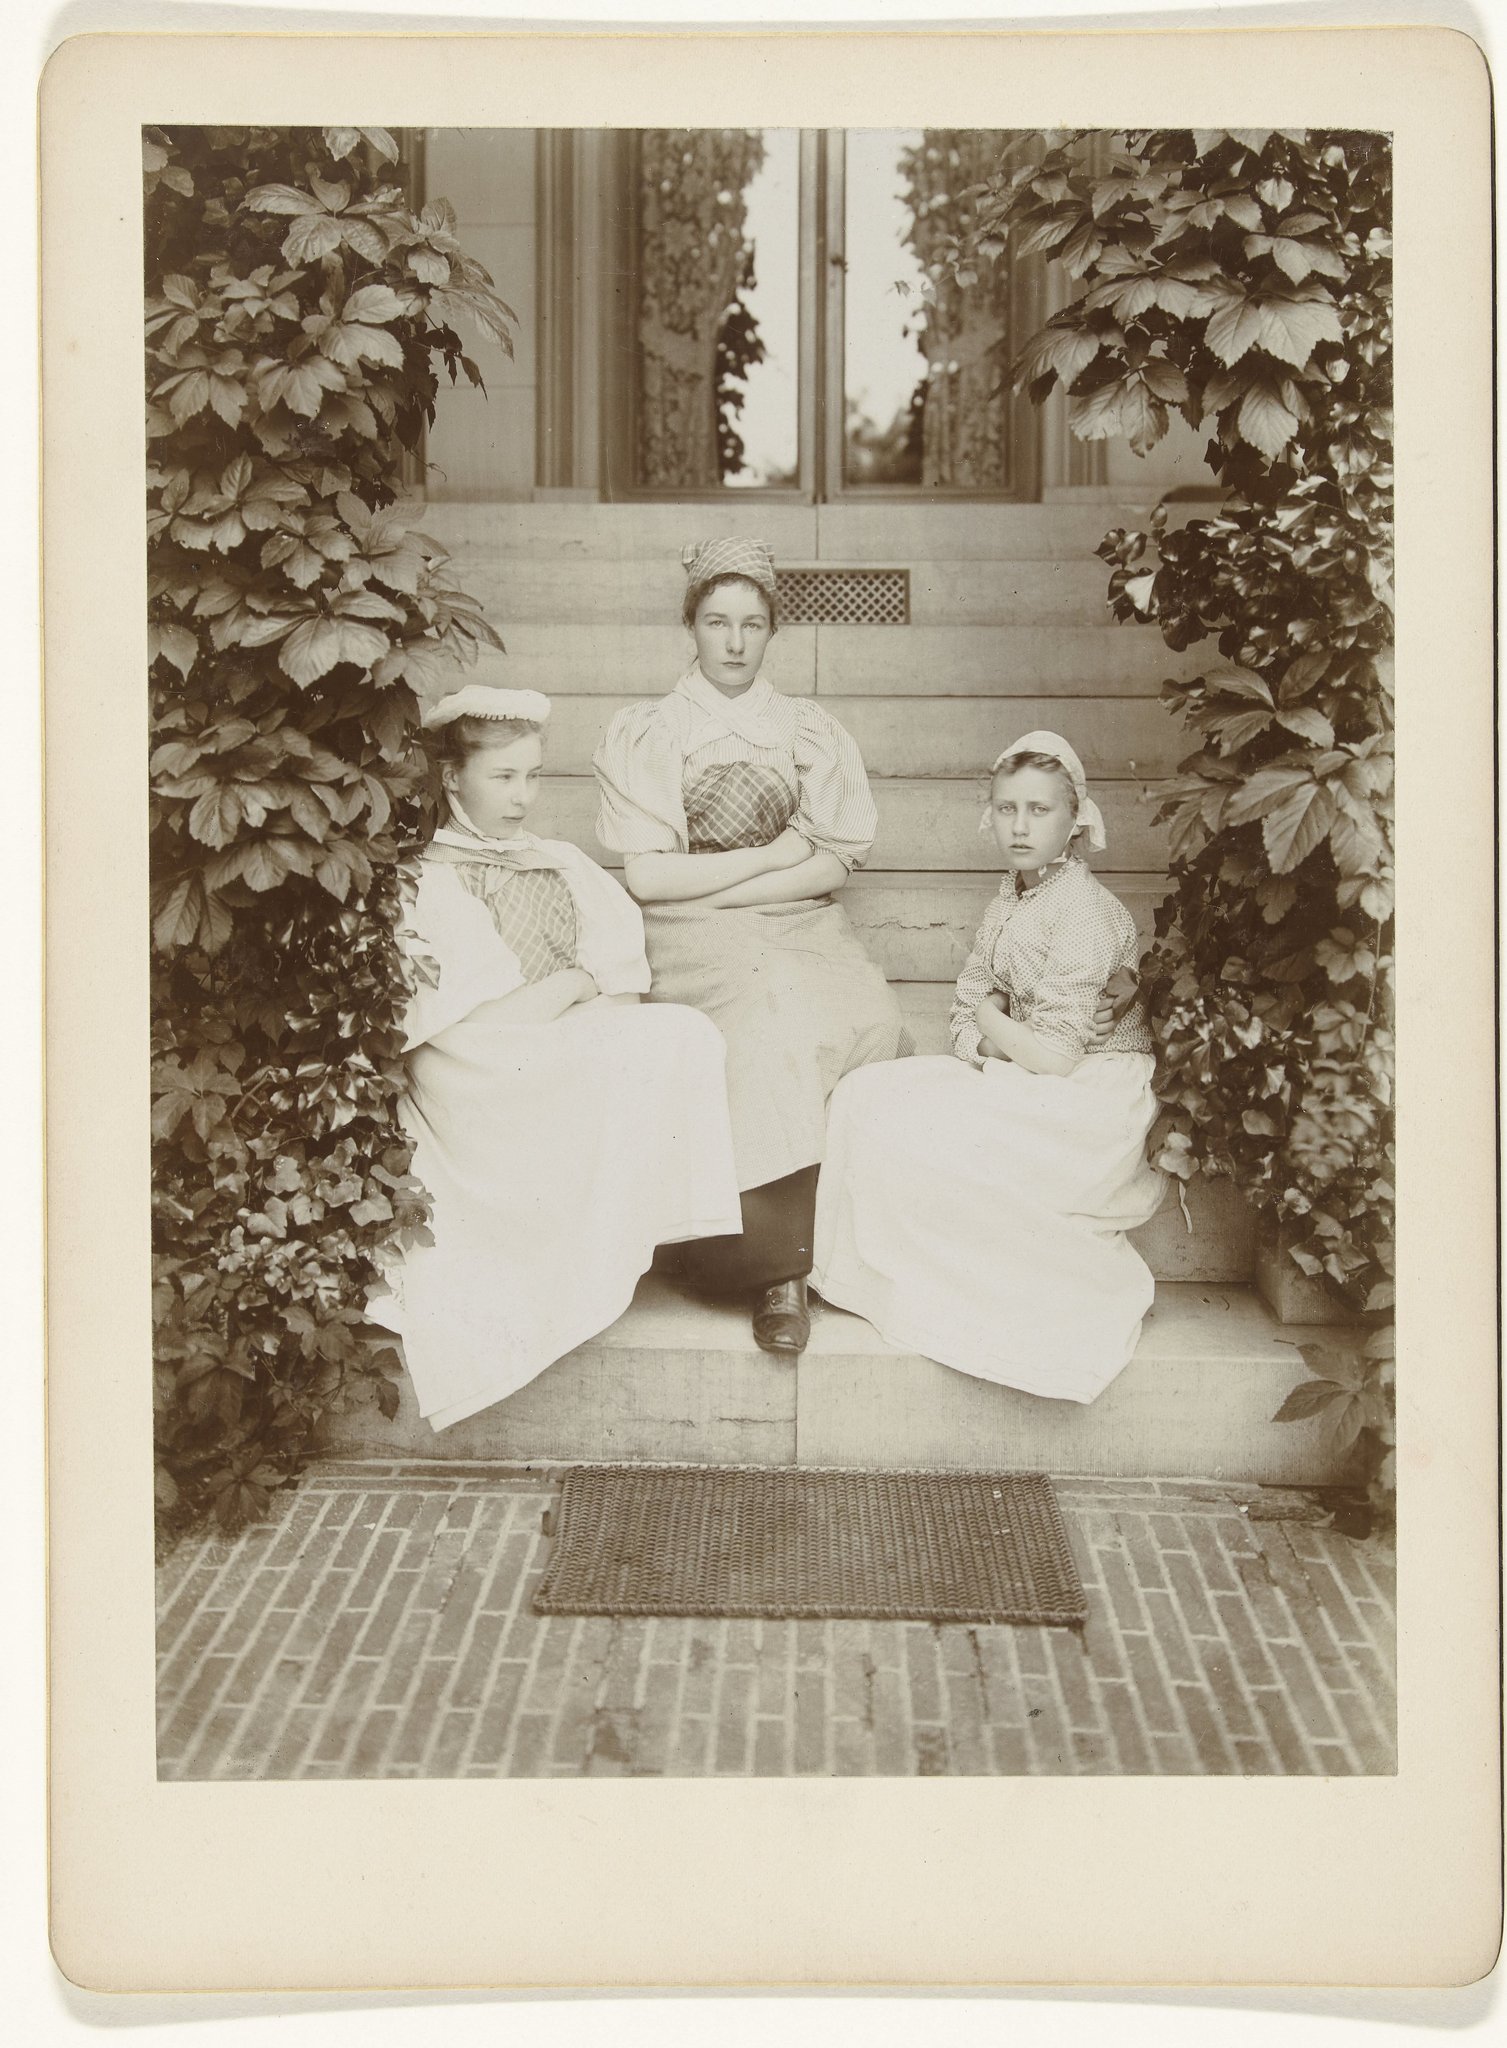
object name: photograph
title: Family Life at Pavia House in Zeist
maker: henry pauw van wieldrecht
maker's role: fotograaf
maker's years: 1863-1912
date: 1808-1897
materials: cardboard, photographic support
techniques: collodion silver print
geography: netherlands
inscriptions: signature and date: ‘H. Pauw v. Wieldrecht. / Augustus 1897.’, annotation: ‘No 1413.’, annotation: ‘personeel van / "Pavia" - Zeist’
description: These photographs reveal Pauw van Wieldrecht’s development from amateur to exceptionally talented photographer. His key subjects were family and domestic life in and around the family homes, travels, outings, and hunting. We see the photographer’s nephew Reinier (1897), brother Maarten defending himself from a charging (stuffed) wild boar (May 1898) and the domestic staff (August 1897).